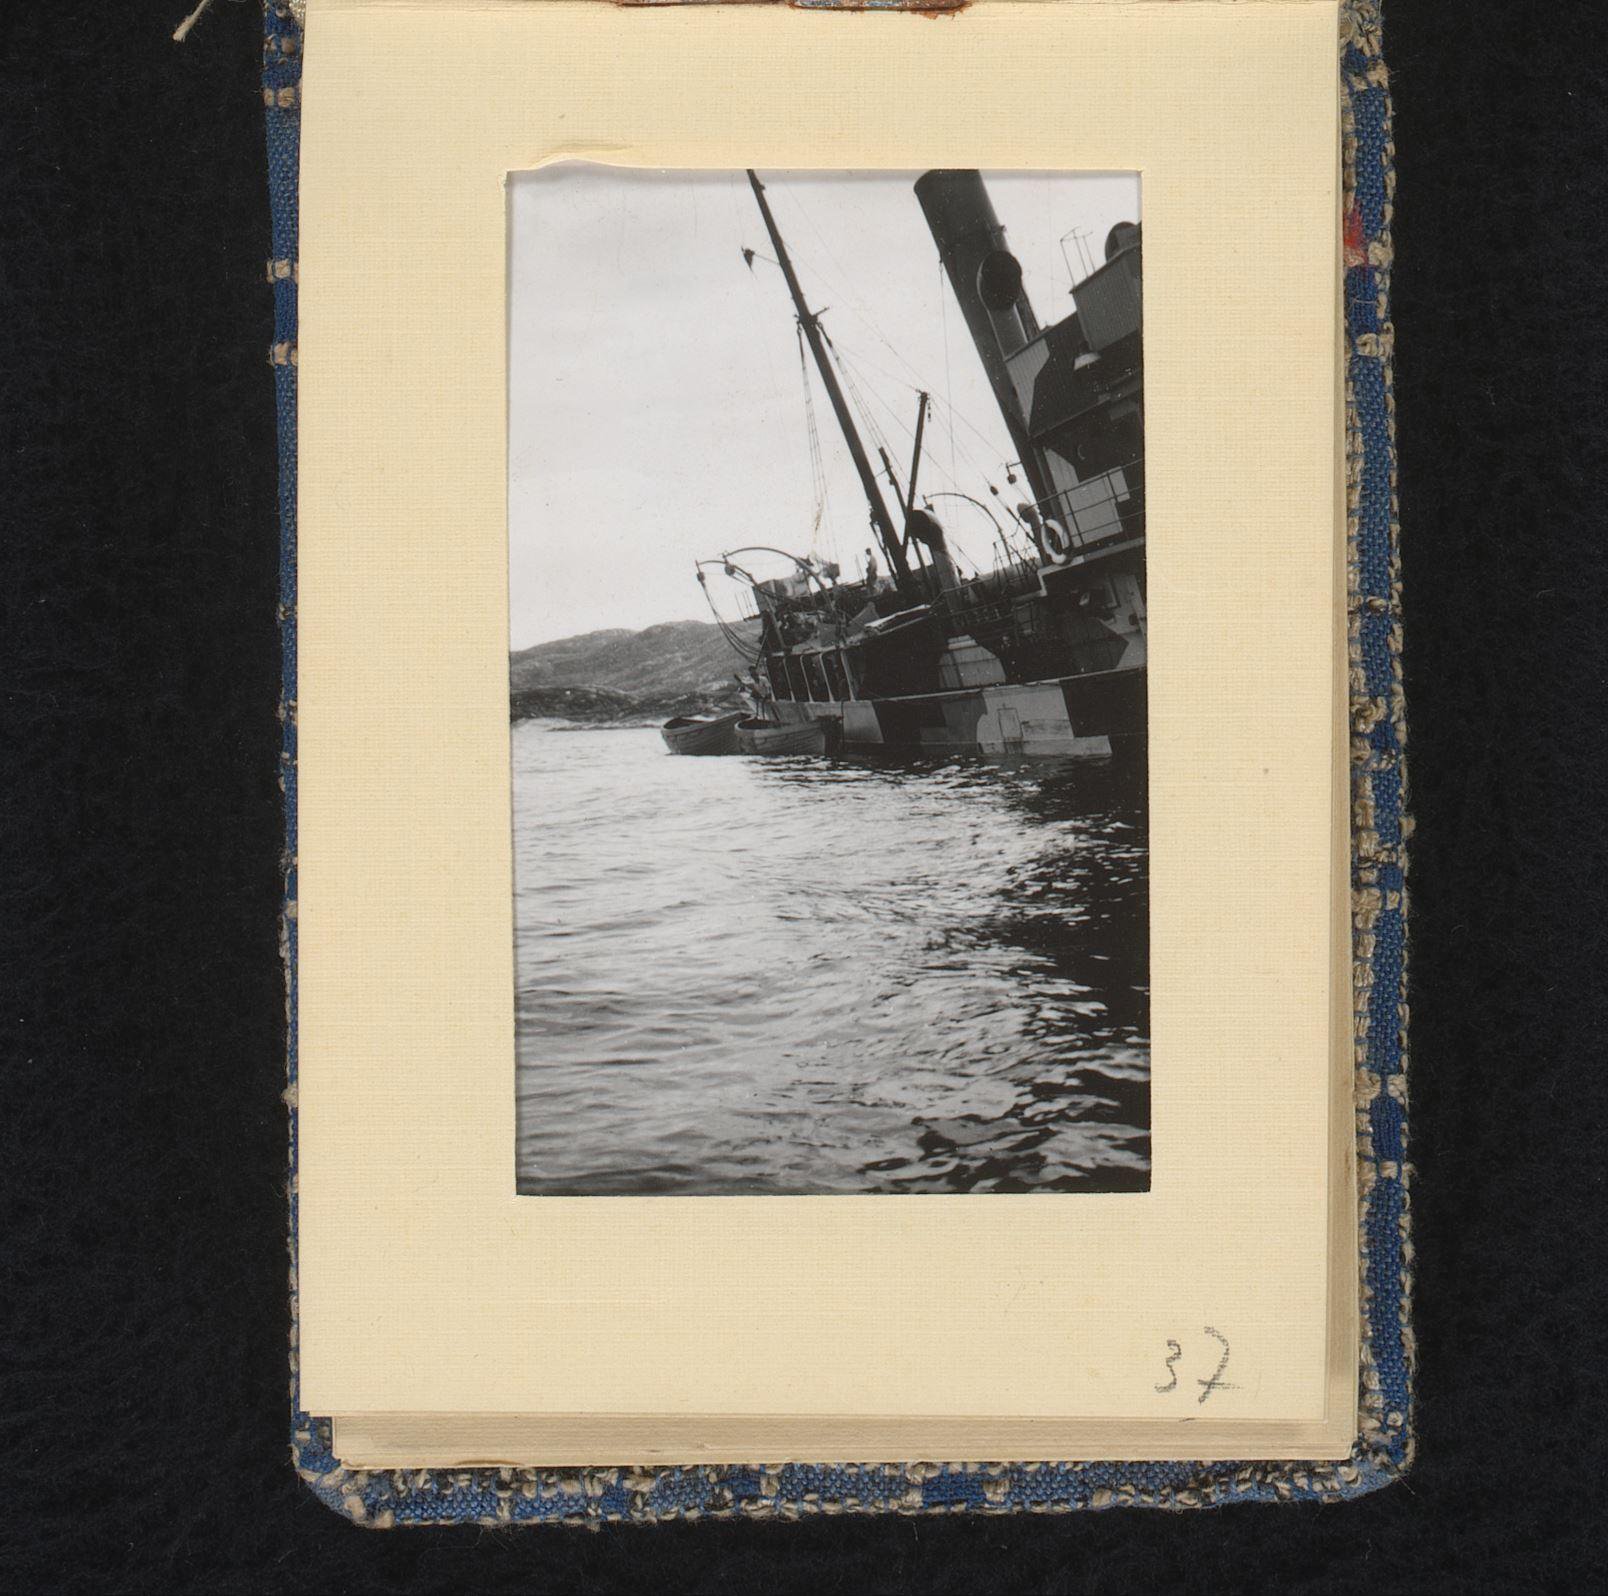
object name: photograph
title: Schip bij kust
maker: Anonymous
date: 1940-1943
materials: photographic support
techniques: gelatin silver print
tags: navy (+ motor ships), camouflage, sailor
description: Twee sloepen langszij een schip geschilderd in camouflage, bij een heuvelachtig kustlandschap. Onderdeel van het fotoalbum over de Kriegsmarine 1940-1943.